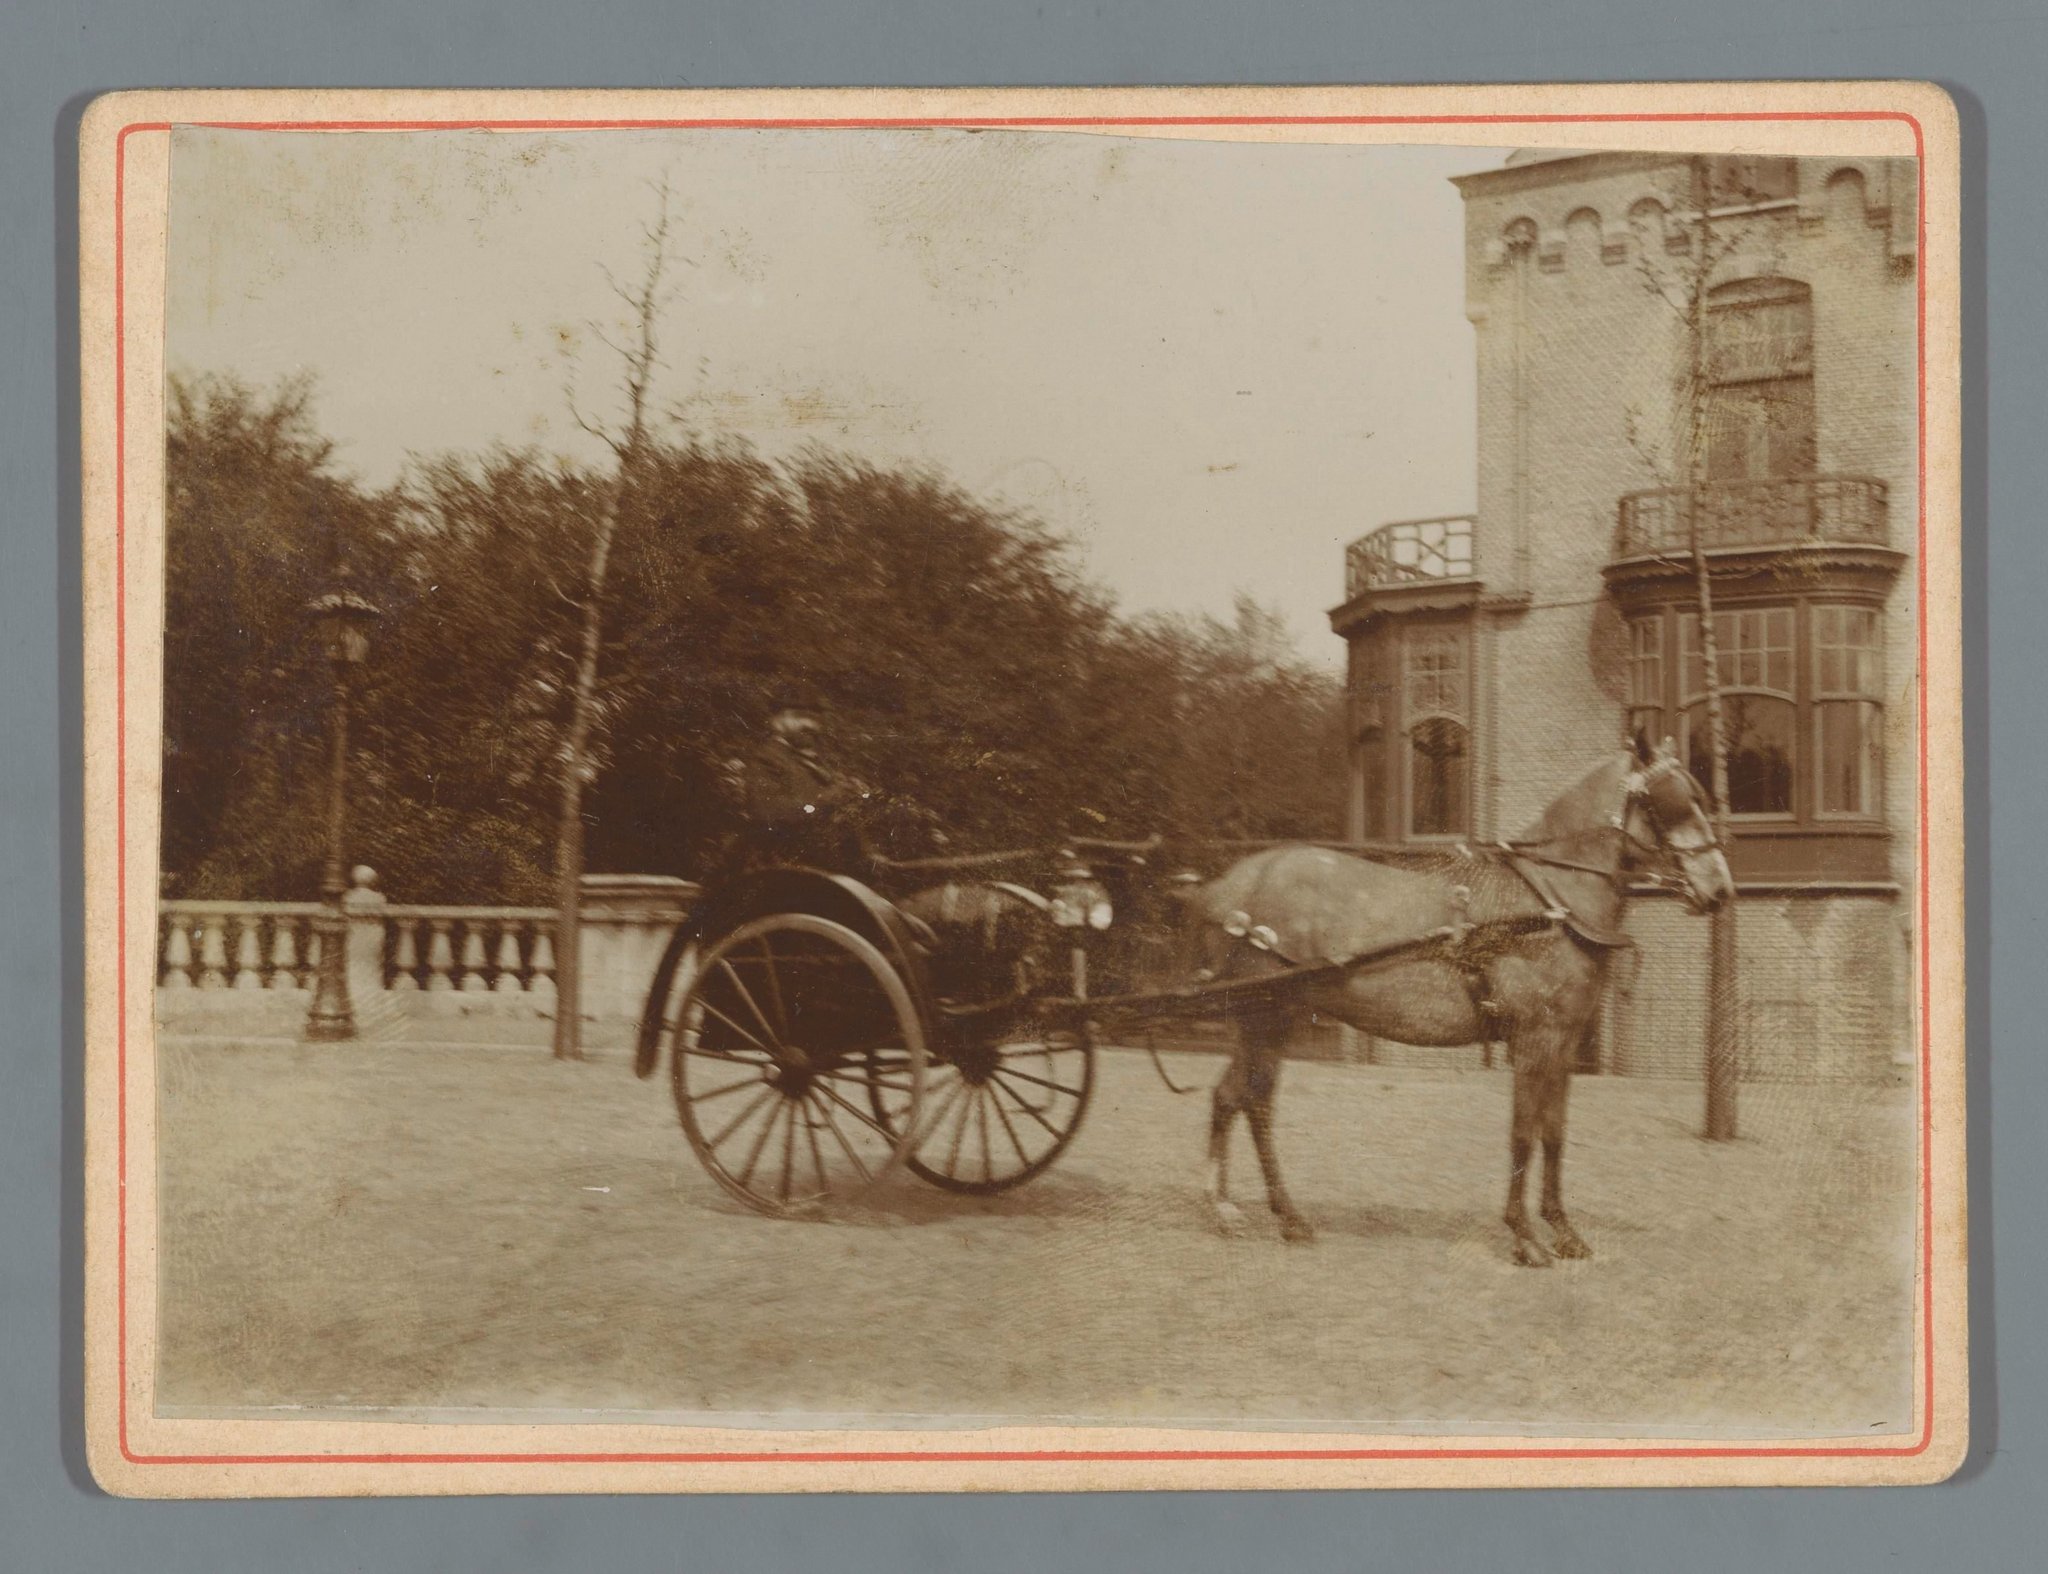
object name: photograph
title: Onbekende man in een rijtuig met paard voor een landhuis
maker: Anonymous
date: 1890-1910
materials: cardboard, photographic support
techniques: gelatin silver print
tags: two-wheeled, animal-drawn vehicle, rural housing, e.g. country-house, villa, cottage, horse